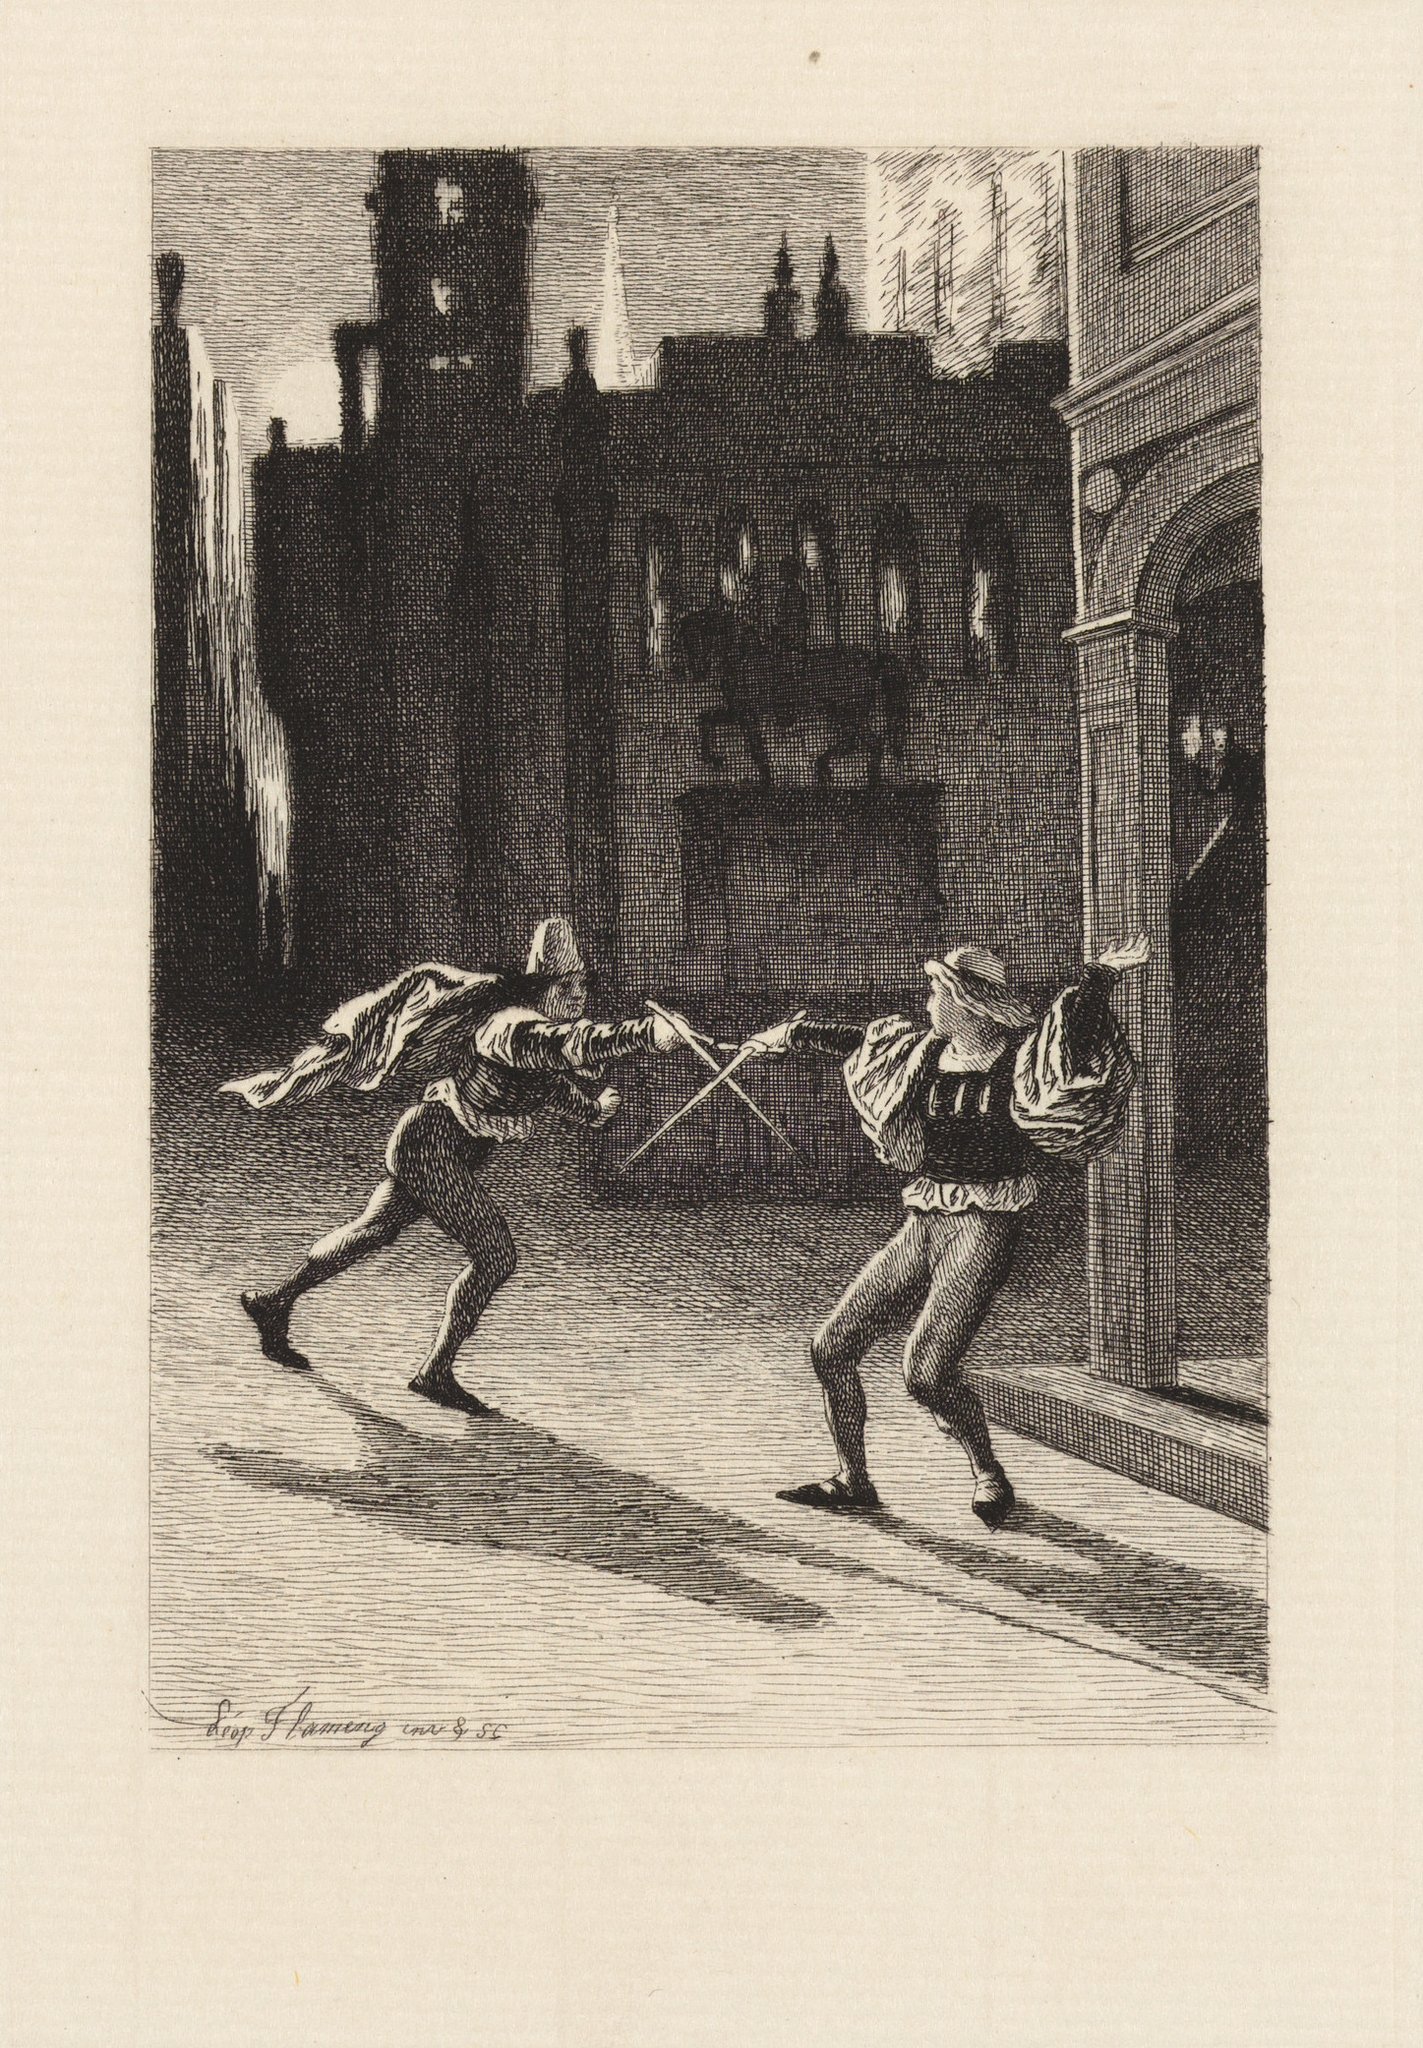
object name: print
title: La Rouerie de Dame Simone, plate 7 from "The Decameron"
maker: léopold flameng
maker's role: engraver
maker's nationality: french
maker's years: 1831-1911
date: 1873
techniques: etching